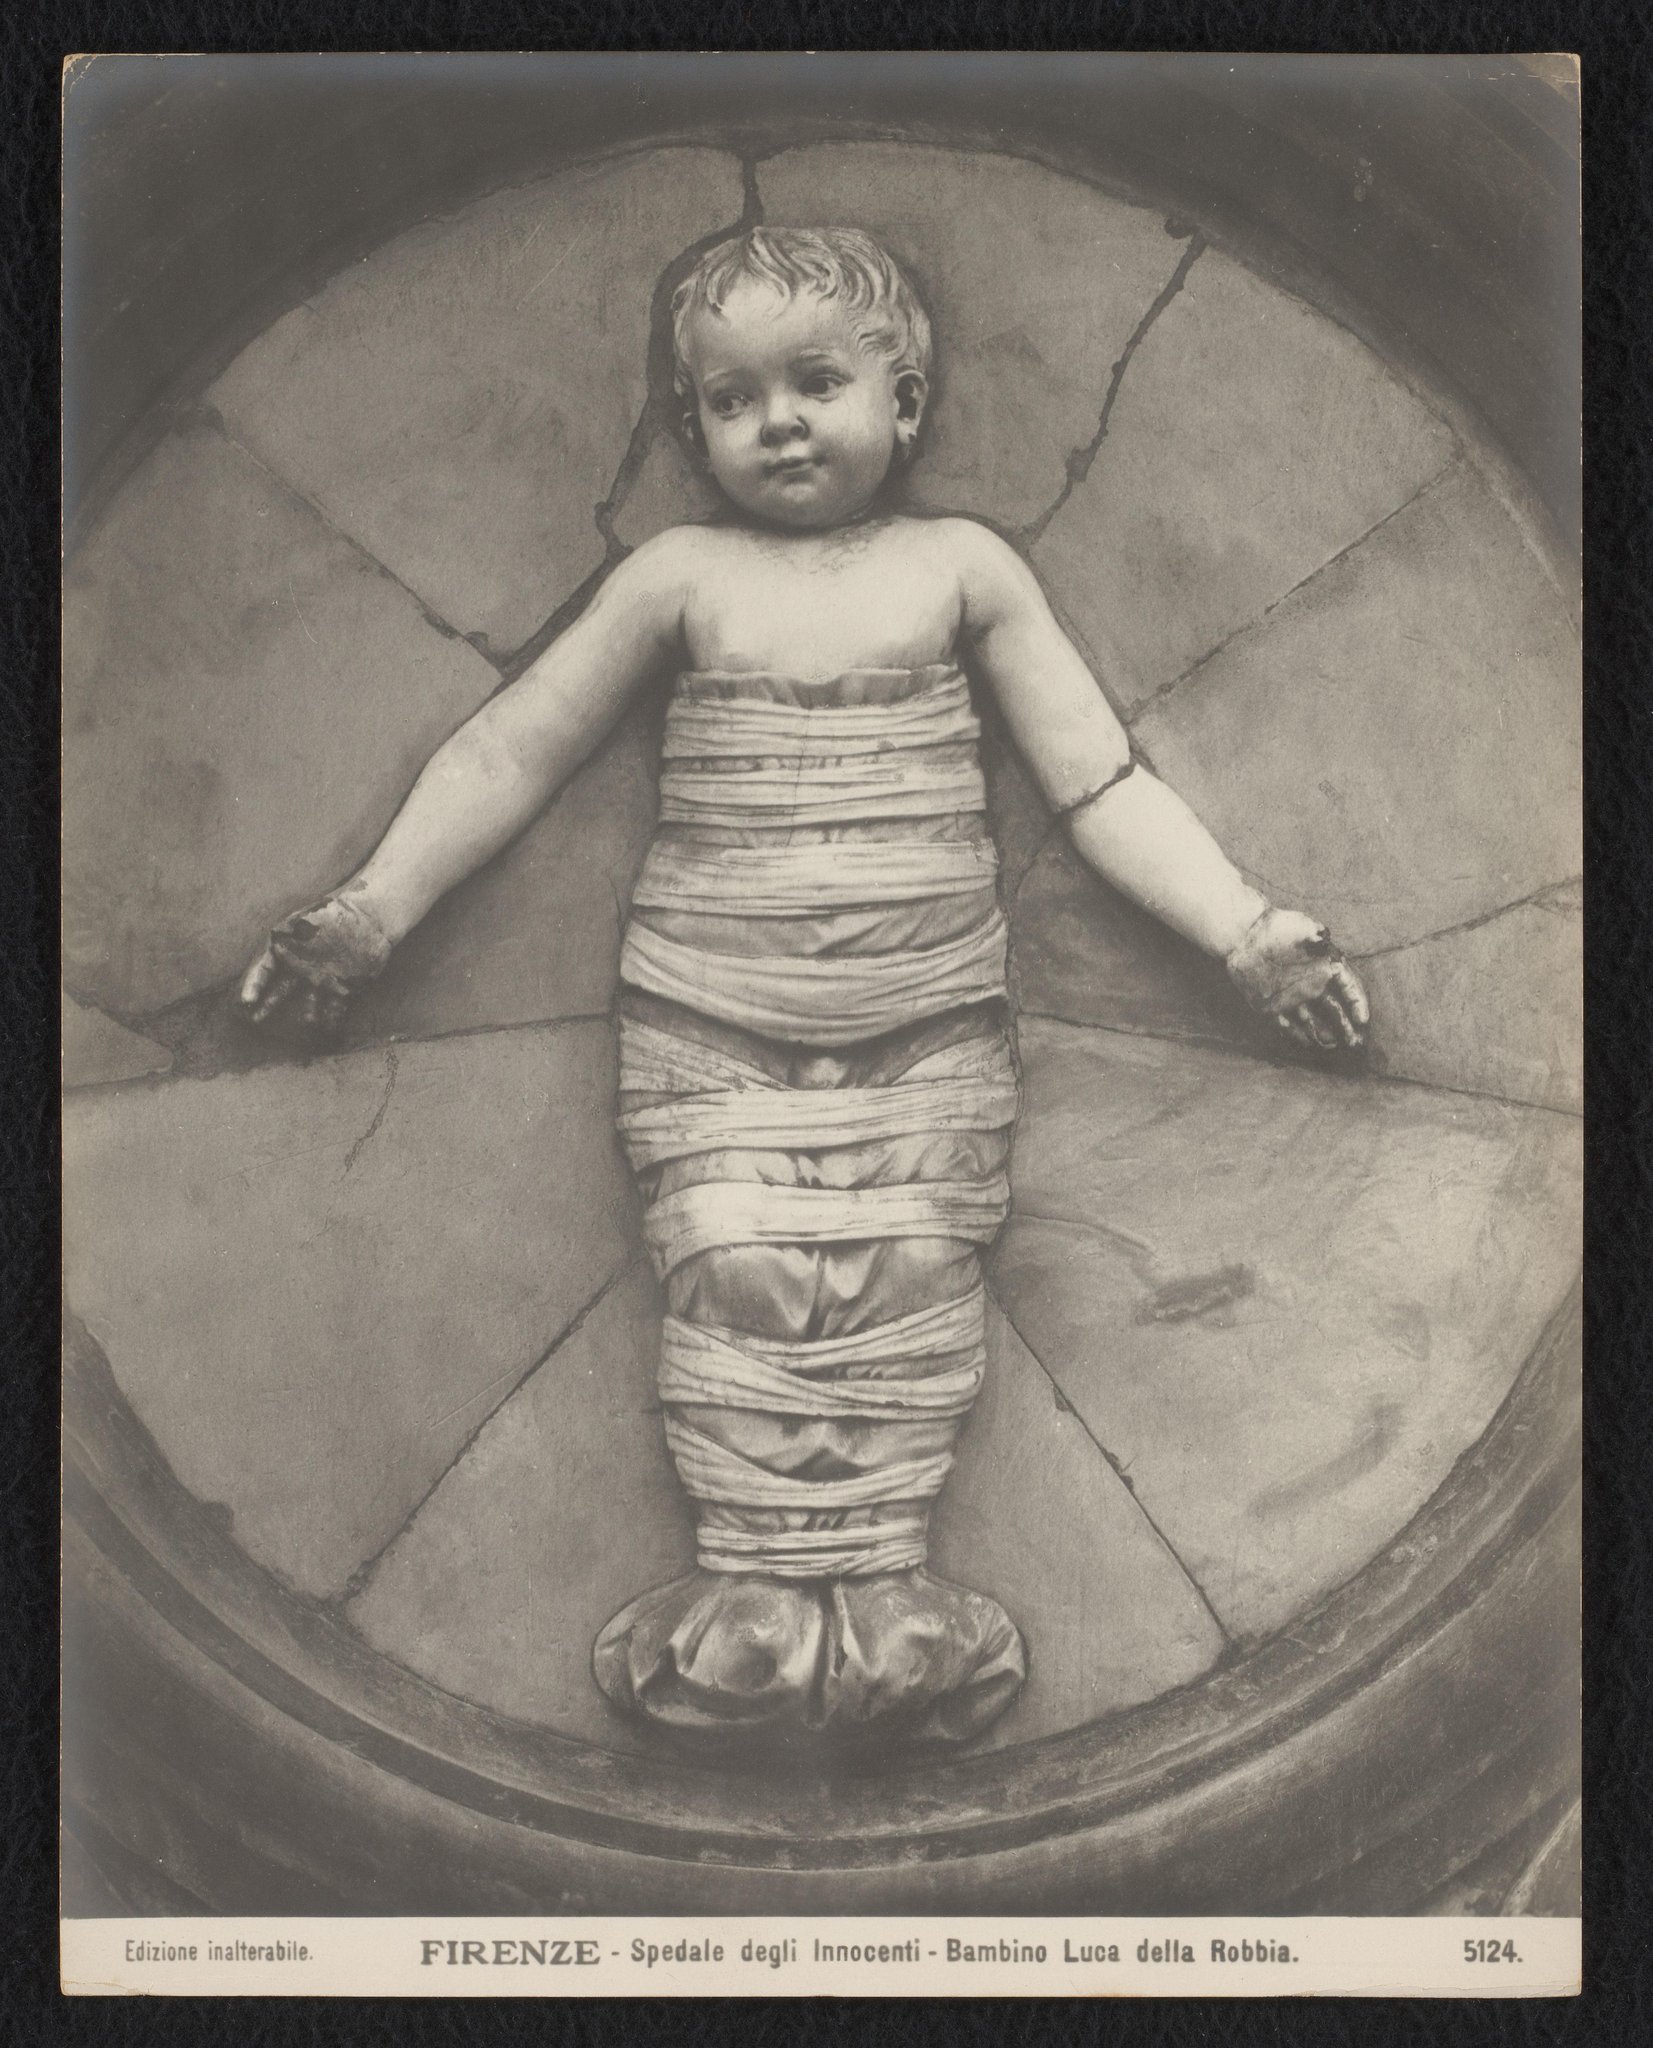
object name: photograph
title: Spedale degli Innocenti - Bambino - Luca della Robbia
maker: Anonymous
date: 1900-1920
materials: paper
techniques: gelatin silver print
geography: florence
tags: art (+ relief ~ sculpture)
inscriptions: collector's mark: ‘RIJKS SCHOOL VOOR KUNSTNIJVERHEID/ GROEP’, inscription: ‘Edizione inalterabile.’, number: ‘5124.’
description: Deze foto maakt deel uit van een omslag.